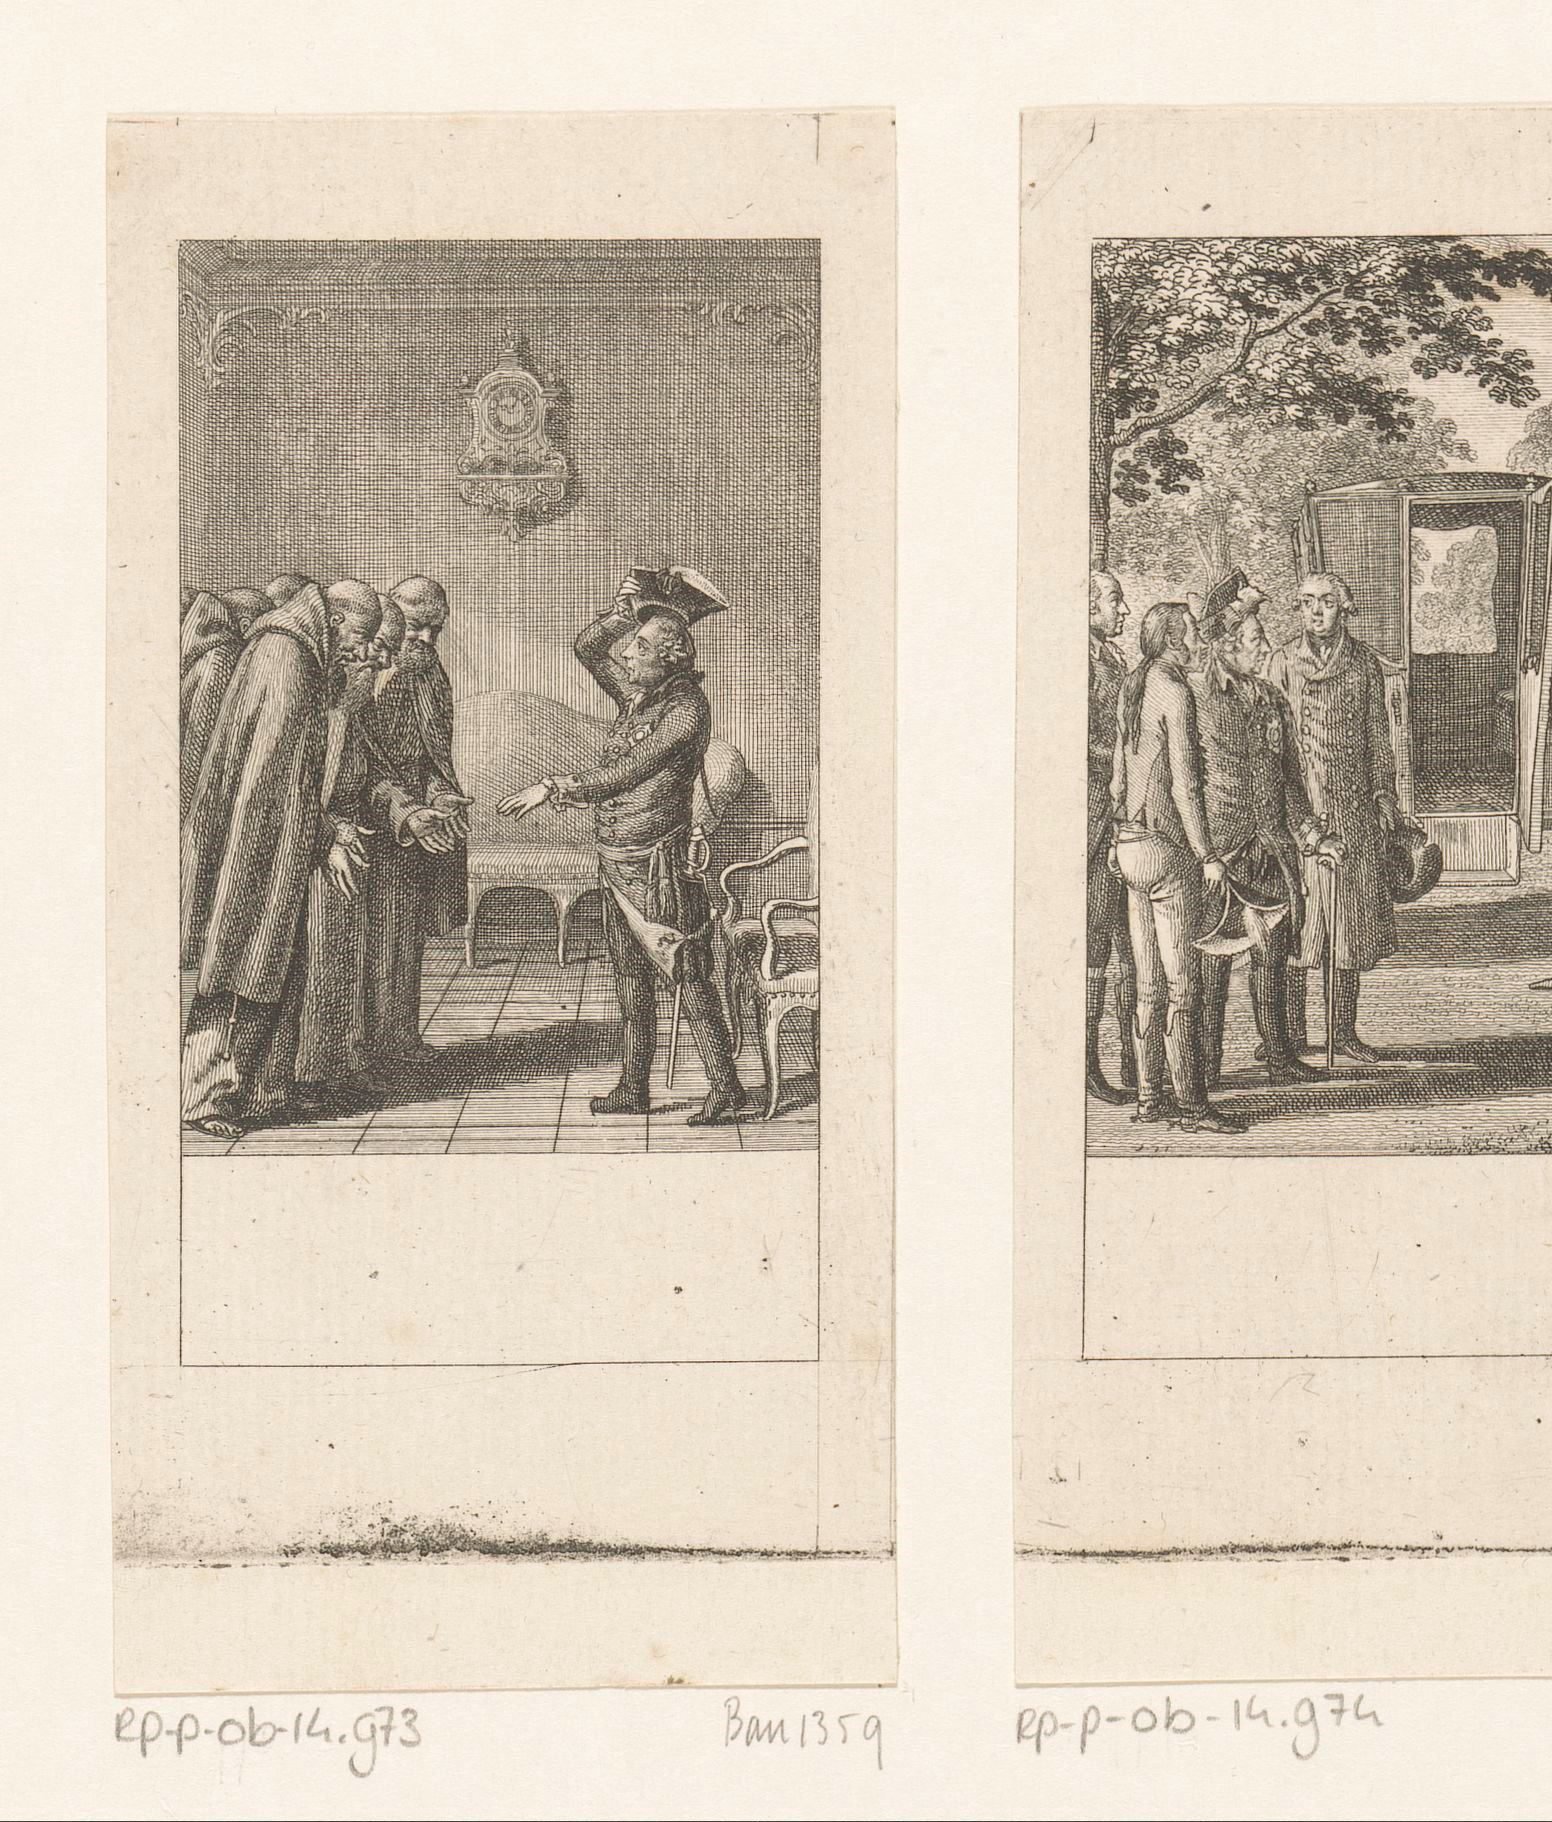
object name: print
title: Frederik II bedankt de kapucijner monniken in Breslau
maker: daniel nikolaus chodowiecki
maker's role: draughtsman, print maker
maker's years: 1726-1801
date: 1788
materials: paper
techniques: etching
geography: berlin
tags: frederick ii (king of prussia), ruler, sovereign, monastic orders, monastic life ~ roman catholic church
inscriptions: collector's mark: Lugt 2228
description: Latere staat gebruikt voor: Gothaischer Hof Kalender zum Nutzen und Vergnügen eingerichtet auf das Jahr 1789. Gotha: C. W. Ettinger, [1788].